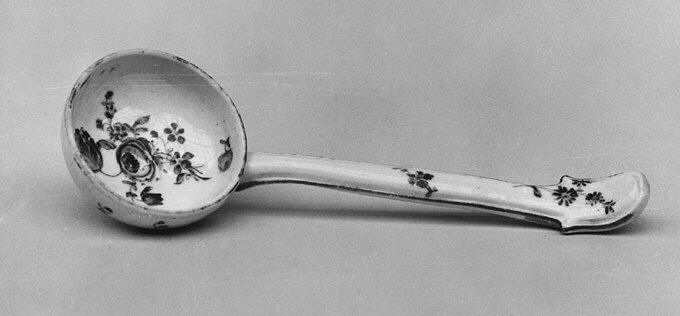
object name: ladle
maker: frankenthal porcelain manufactory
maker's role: manufactory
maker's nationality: german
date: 1756-1759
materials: hard paste porcelain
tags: flowers,ladles